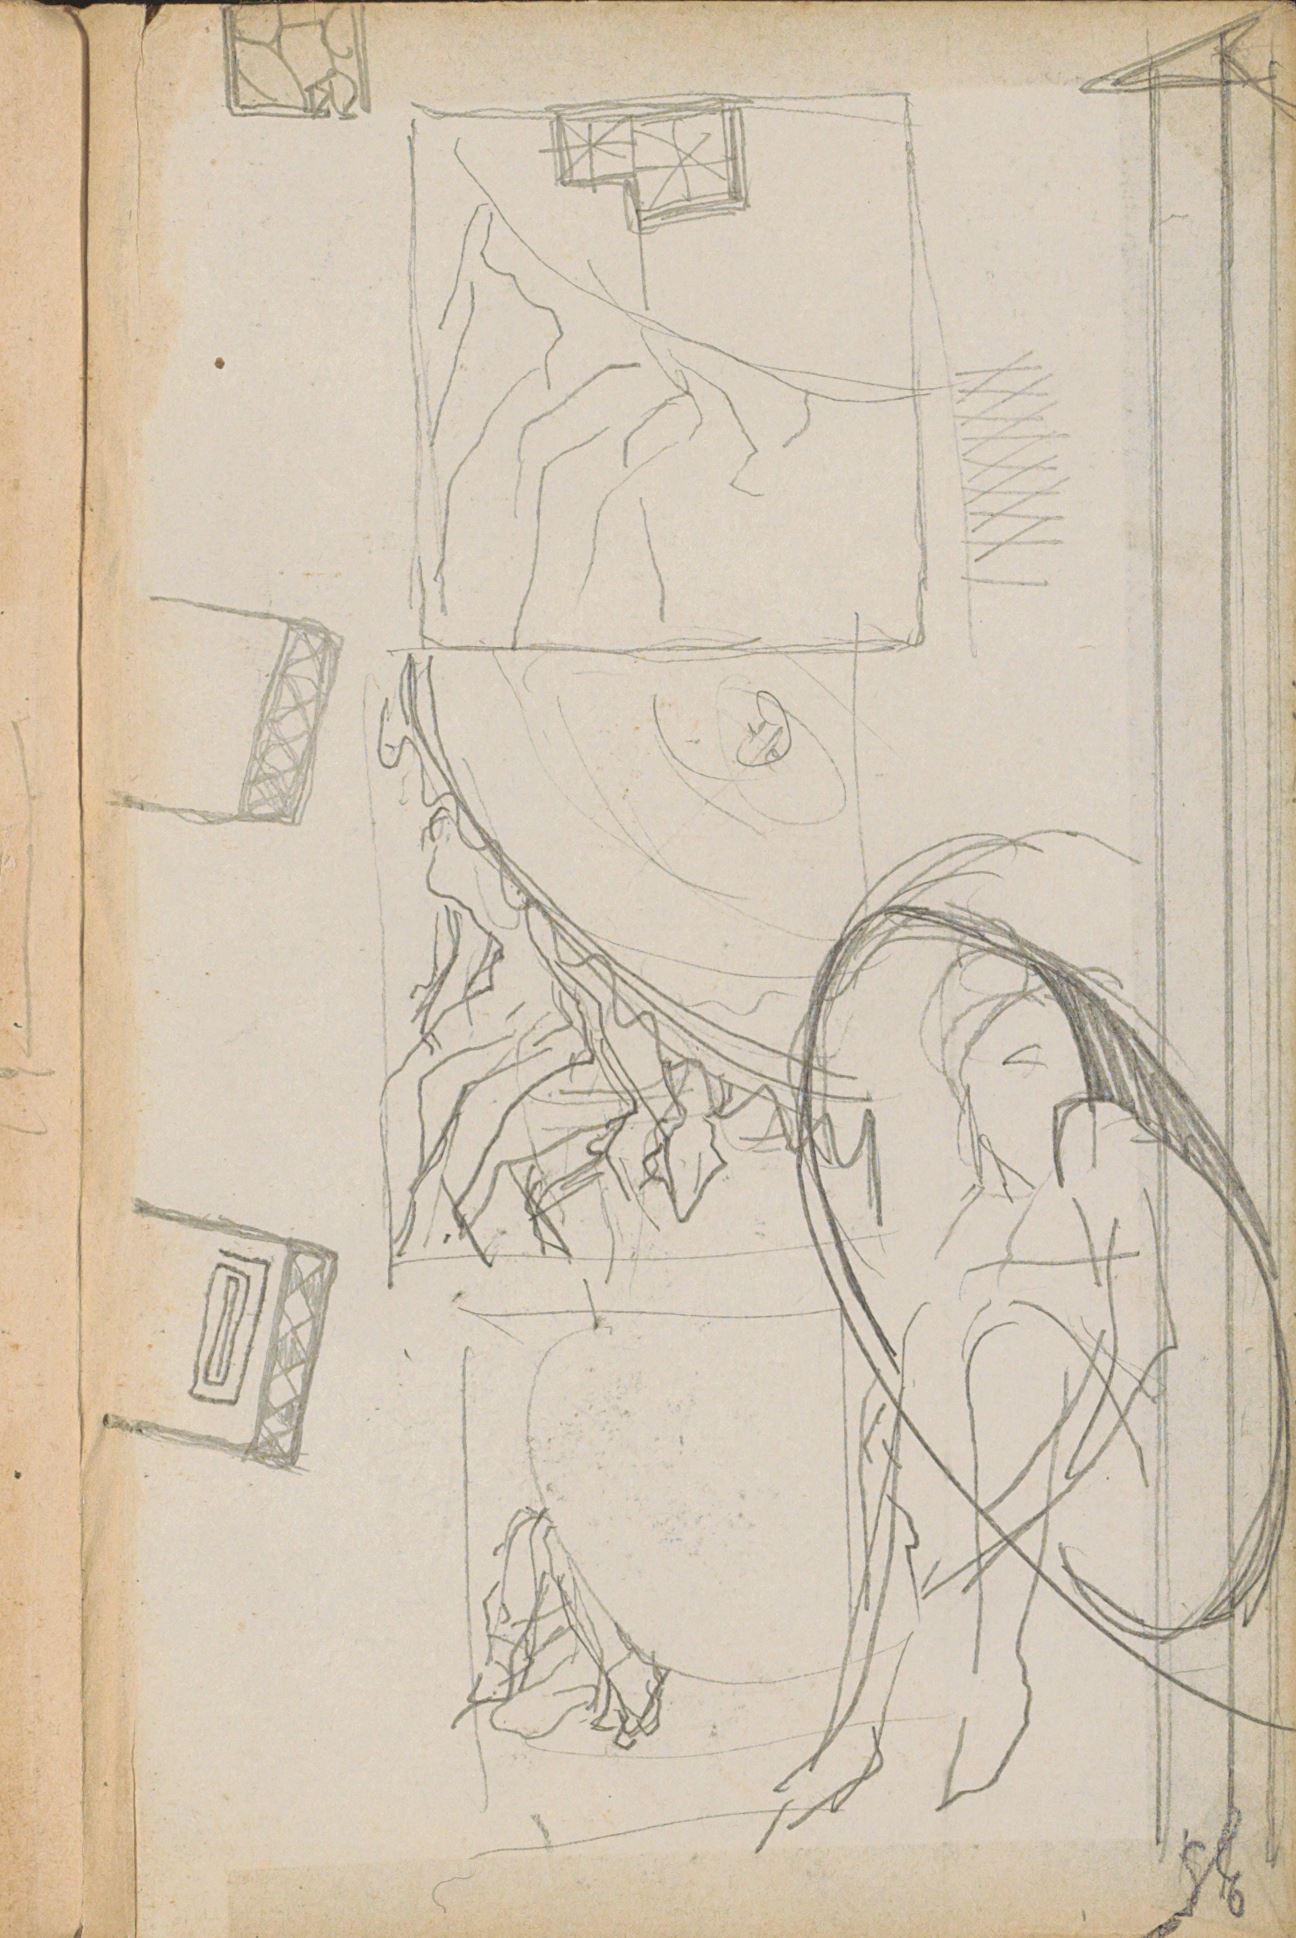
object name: endleaf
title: Studieblad, onder andere met een zittende figuur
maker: reijer stolk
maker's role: draughtsman, print maker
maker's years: 1896-1945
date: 1908-1919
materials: pencil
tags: sitting figure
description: Achterste schutblad uit een schetsboek met 33 bladen.